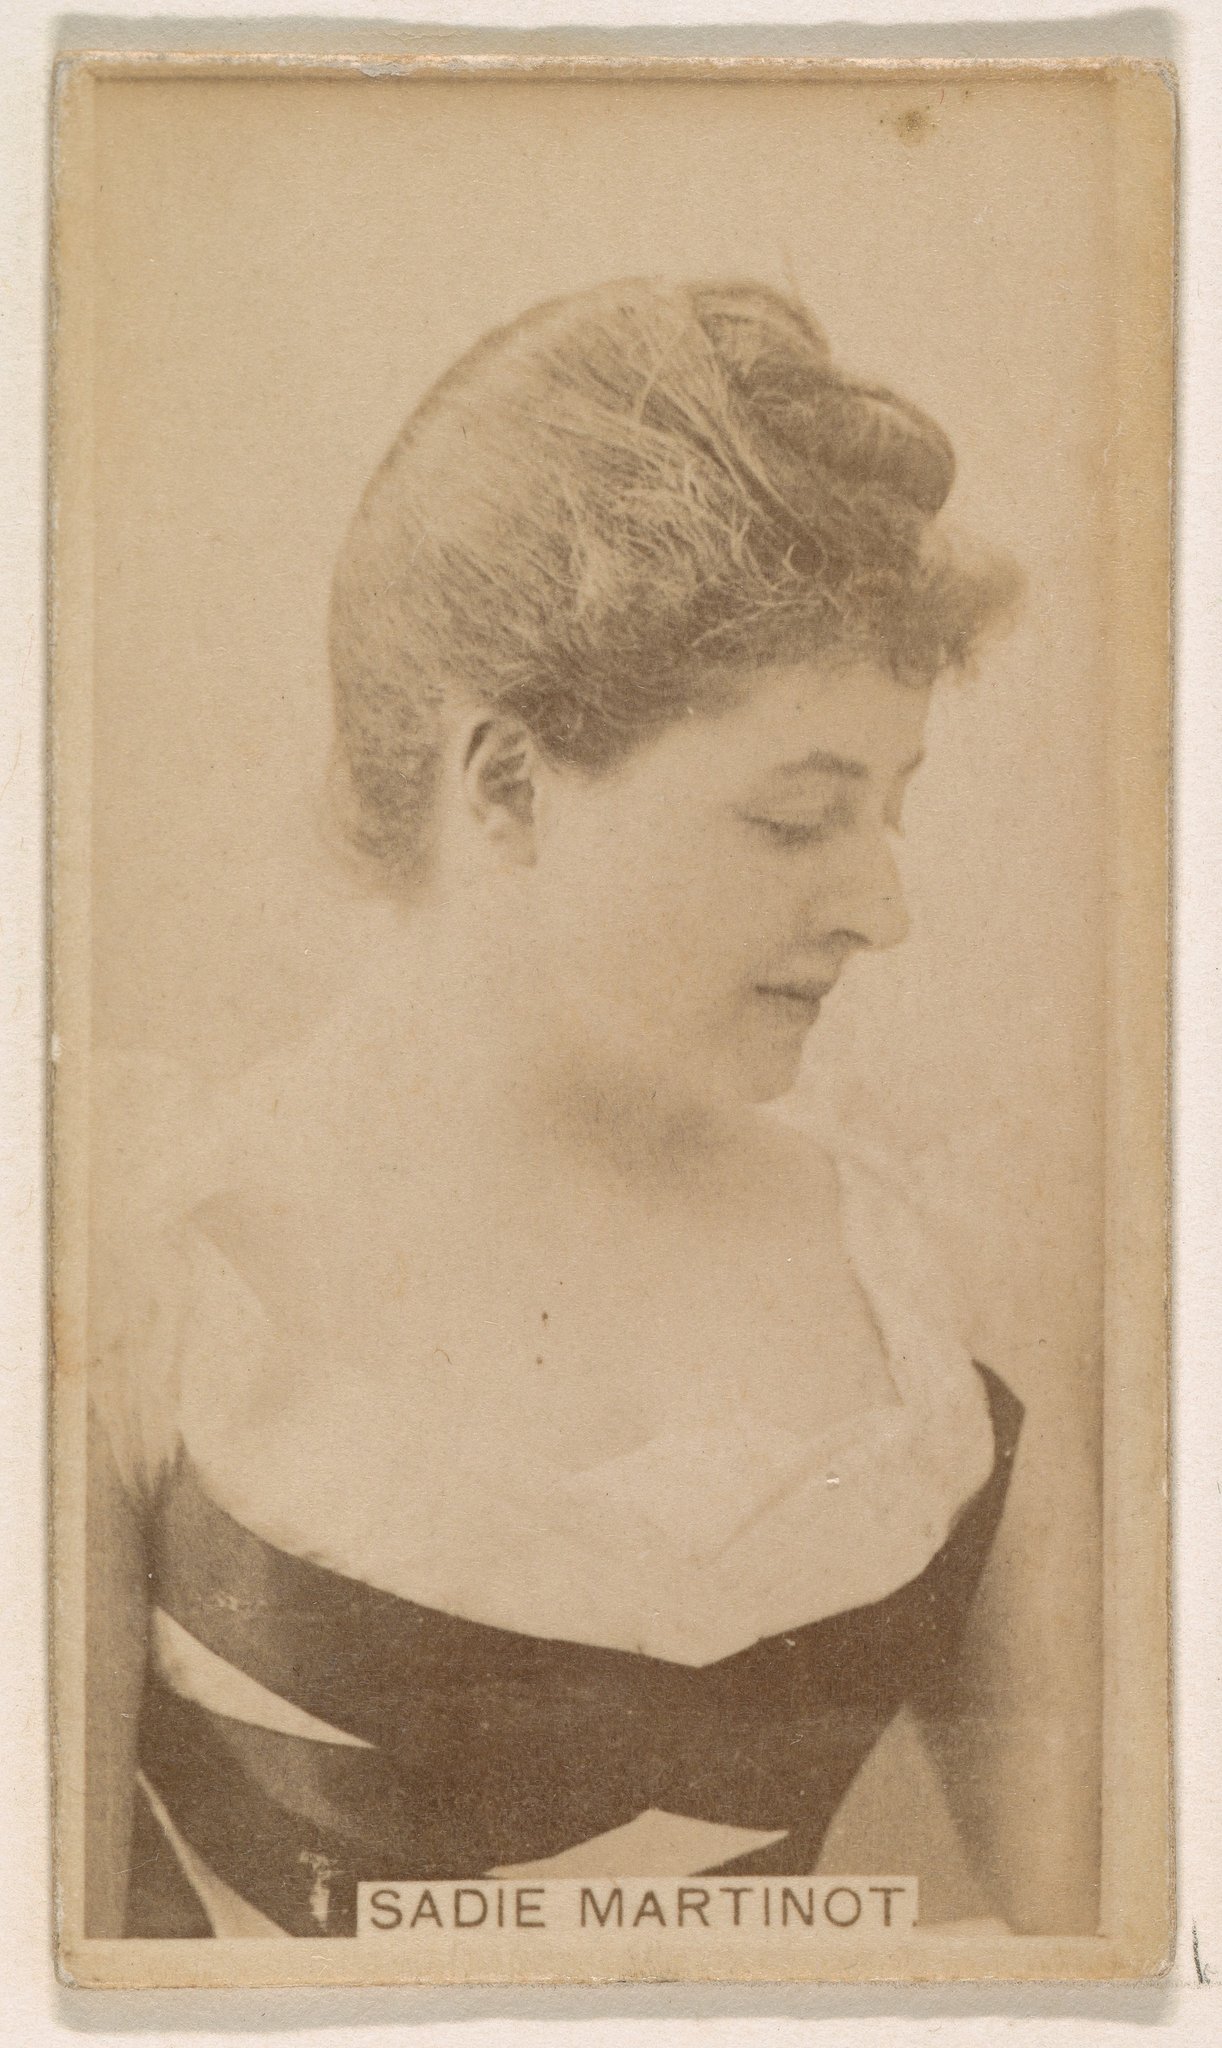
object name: photograph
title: Sadie Martinot, from the Actresses series (N245) issued by Kinney Brothers to promote Sweet Caporal Cigarettes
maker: kinney brothers tobacco company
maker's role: publisher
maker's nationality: american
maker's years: 1869-2011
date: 1890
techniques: albumen silver print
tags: portraits,women,actresses